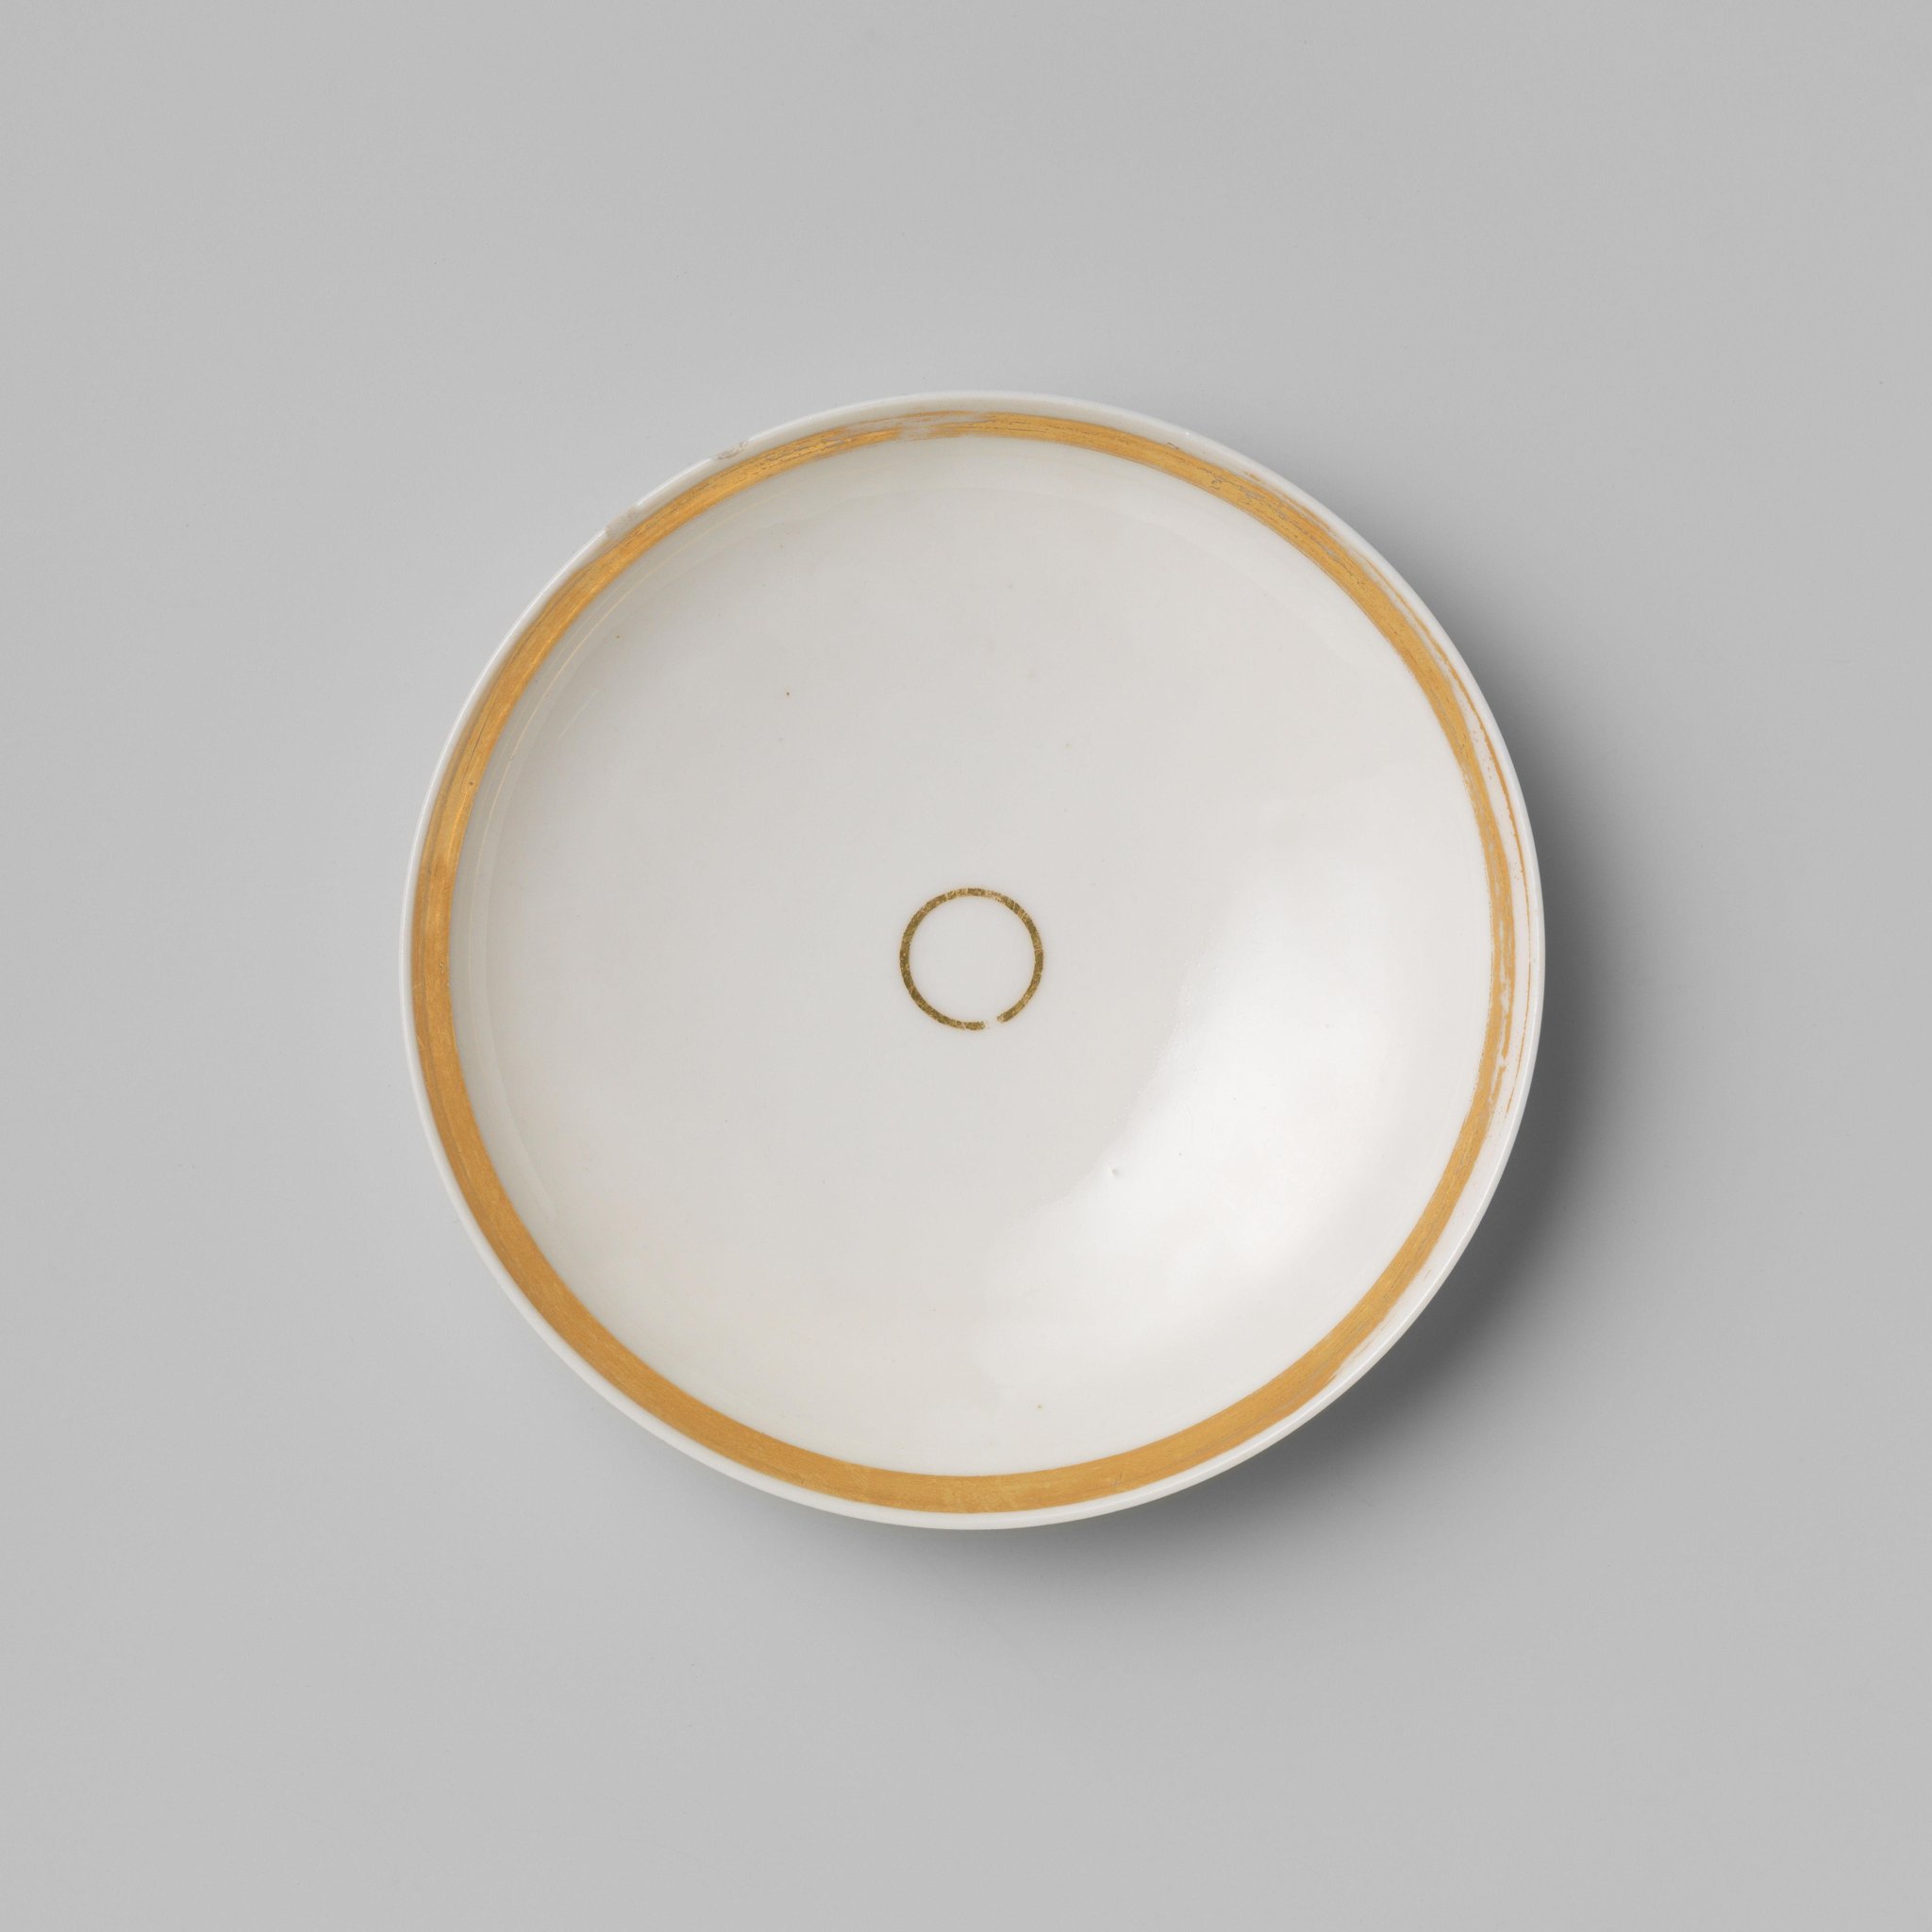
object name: platter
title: Saucer with a medallion and gold border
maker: Anonymous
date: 1850-1899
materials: glaze, gold, paint, porcelain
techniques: firing, forming, gilding, turning, vitrification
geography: europe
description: Schotel van porselein met langs de schotelrand een brede gouden bies en midden op het plat een gouden cirkel. Behoort bij een serie van twaalf kop en schotels waarvan de koppen zijn versierd met een drukdecor in zwart, voorstellende spelende kinderen of volwassenen in een landschap.